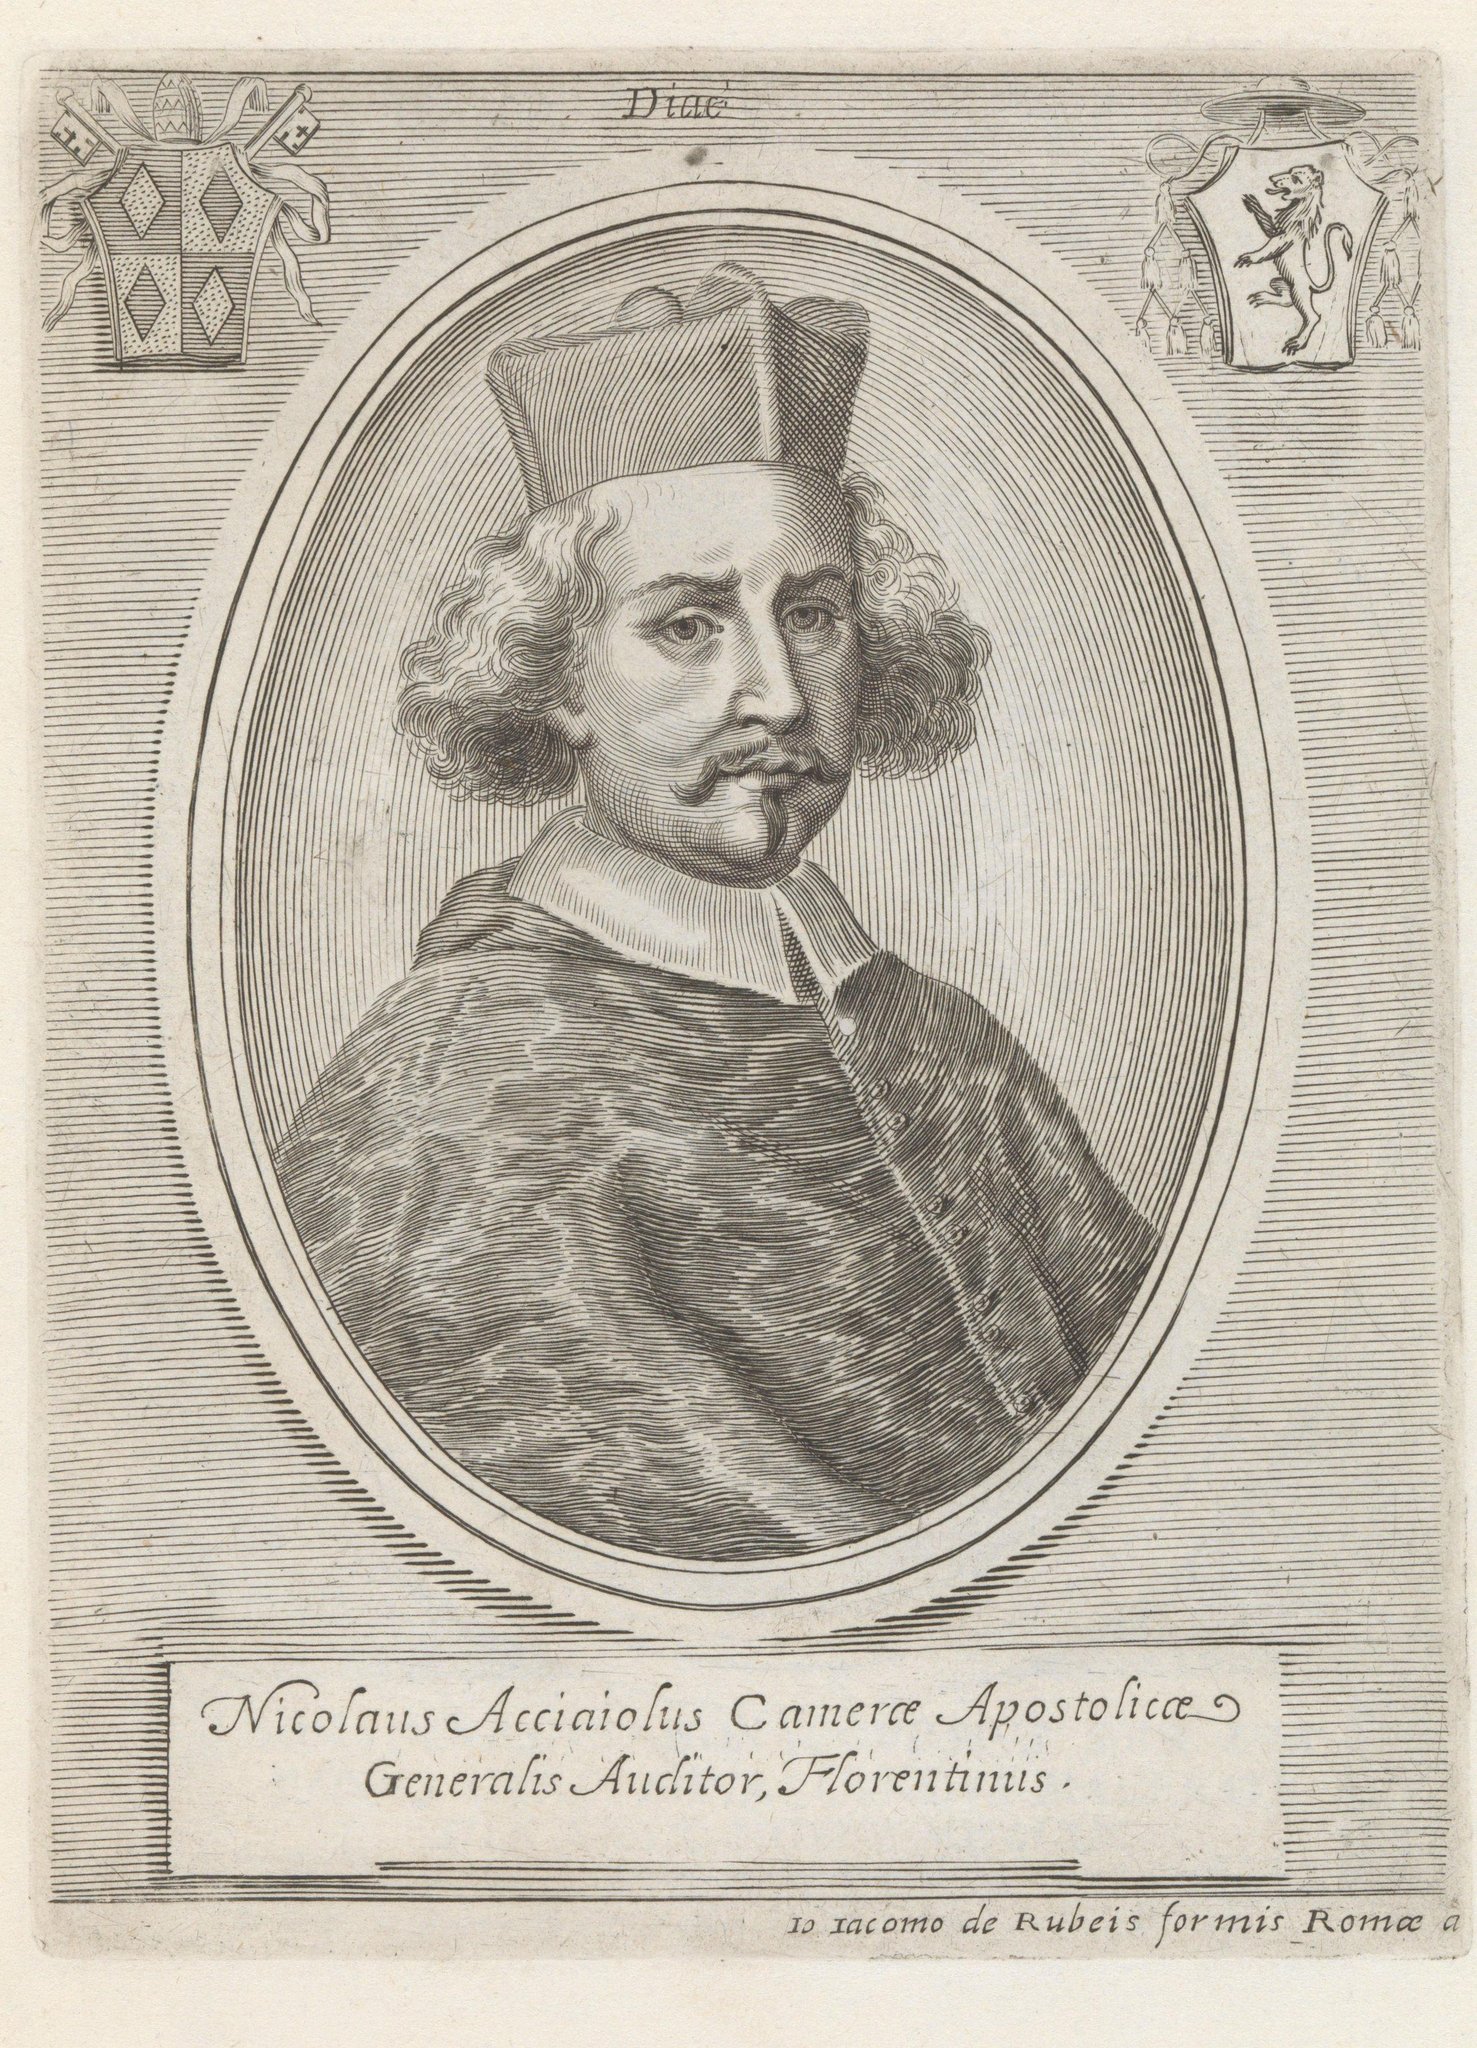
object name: album leaf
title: Portret van kardinaal Nicolò Acciaioli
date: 1669-1691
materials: paper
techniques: engraving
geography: rome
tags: rome, cardinal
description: Portret van kardinaal Nicolò Acciaioli. Linksboven het wapen van paus Clemens IX en rechtsboven het wapen van de kardinaal. Onderaan een onderschrift in het Latijn. De prent maakt deel uit van een album.